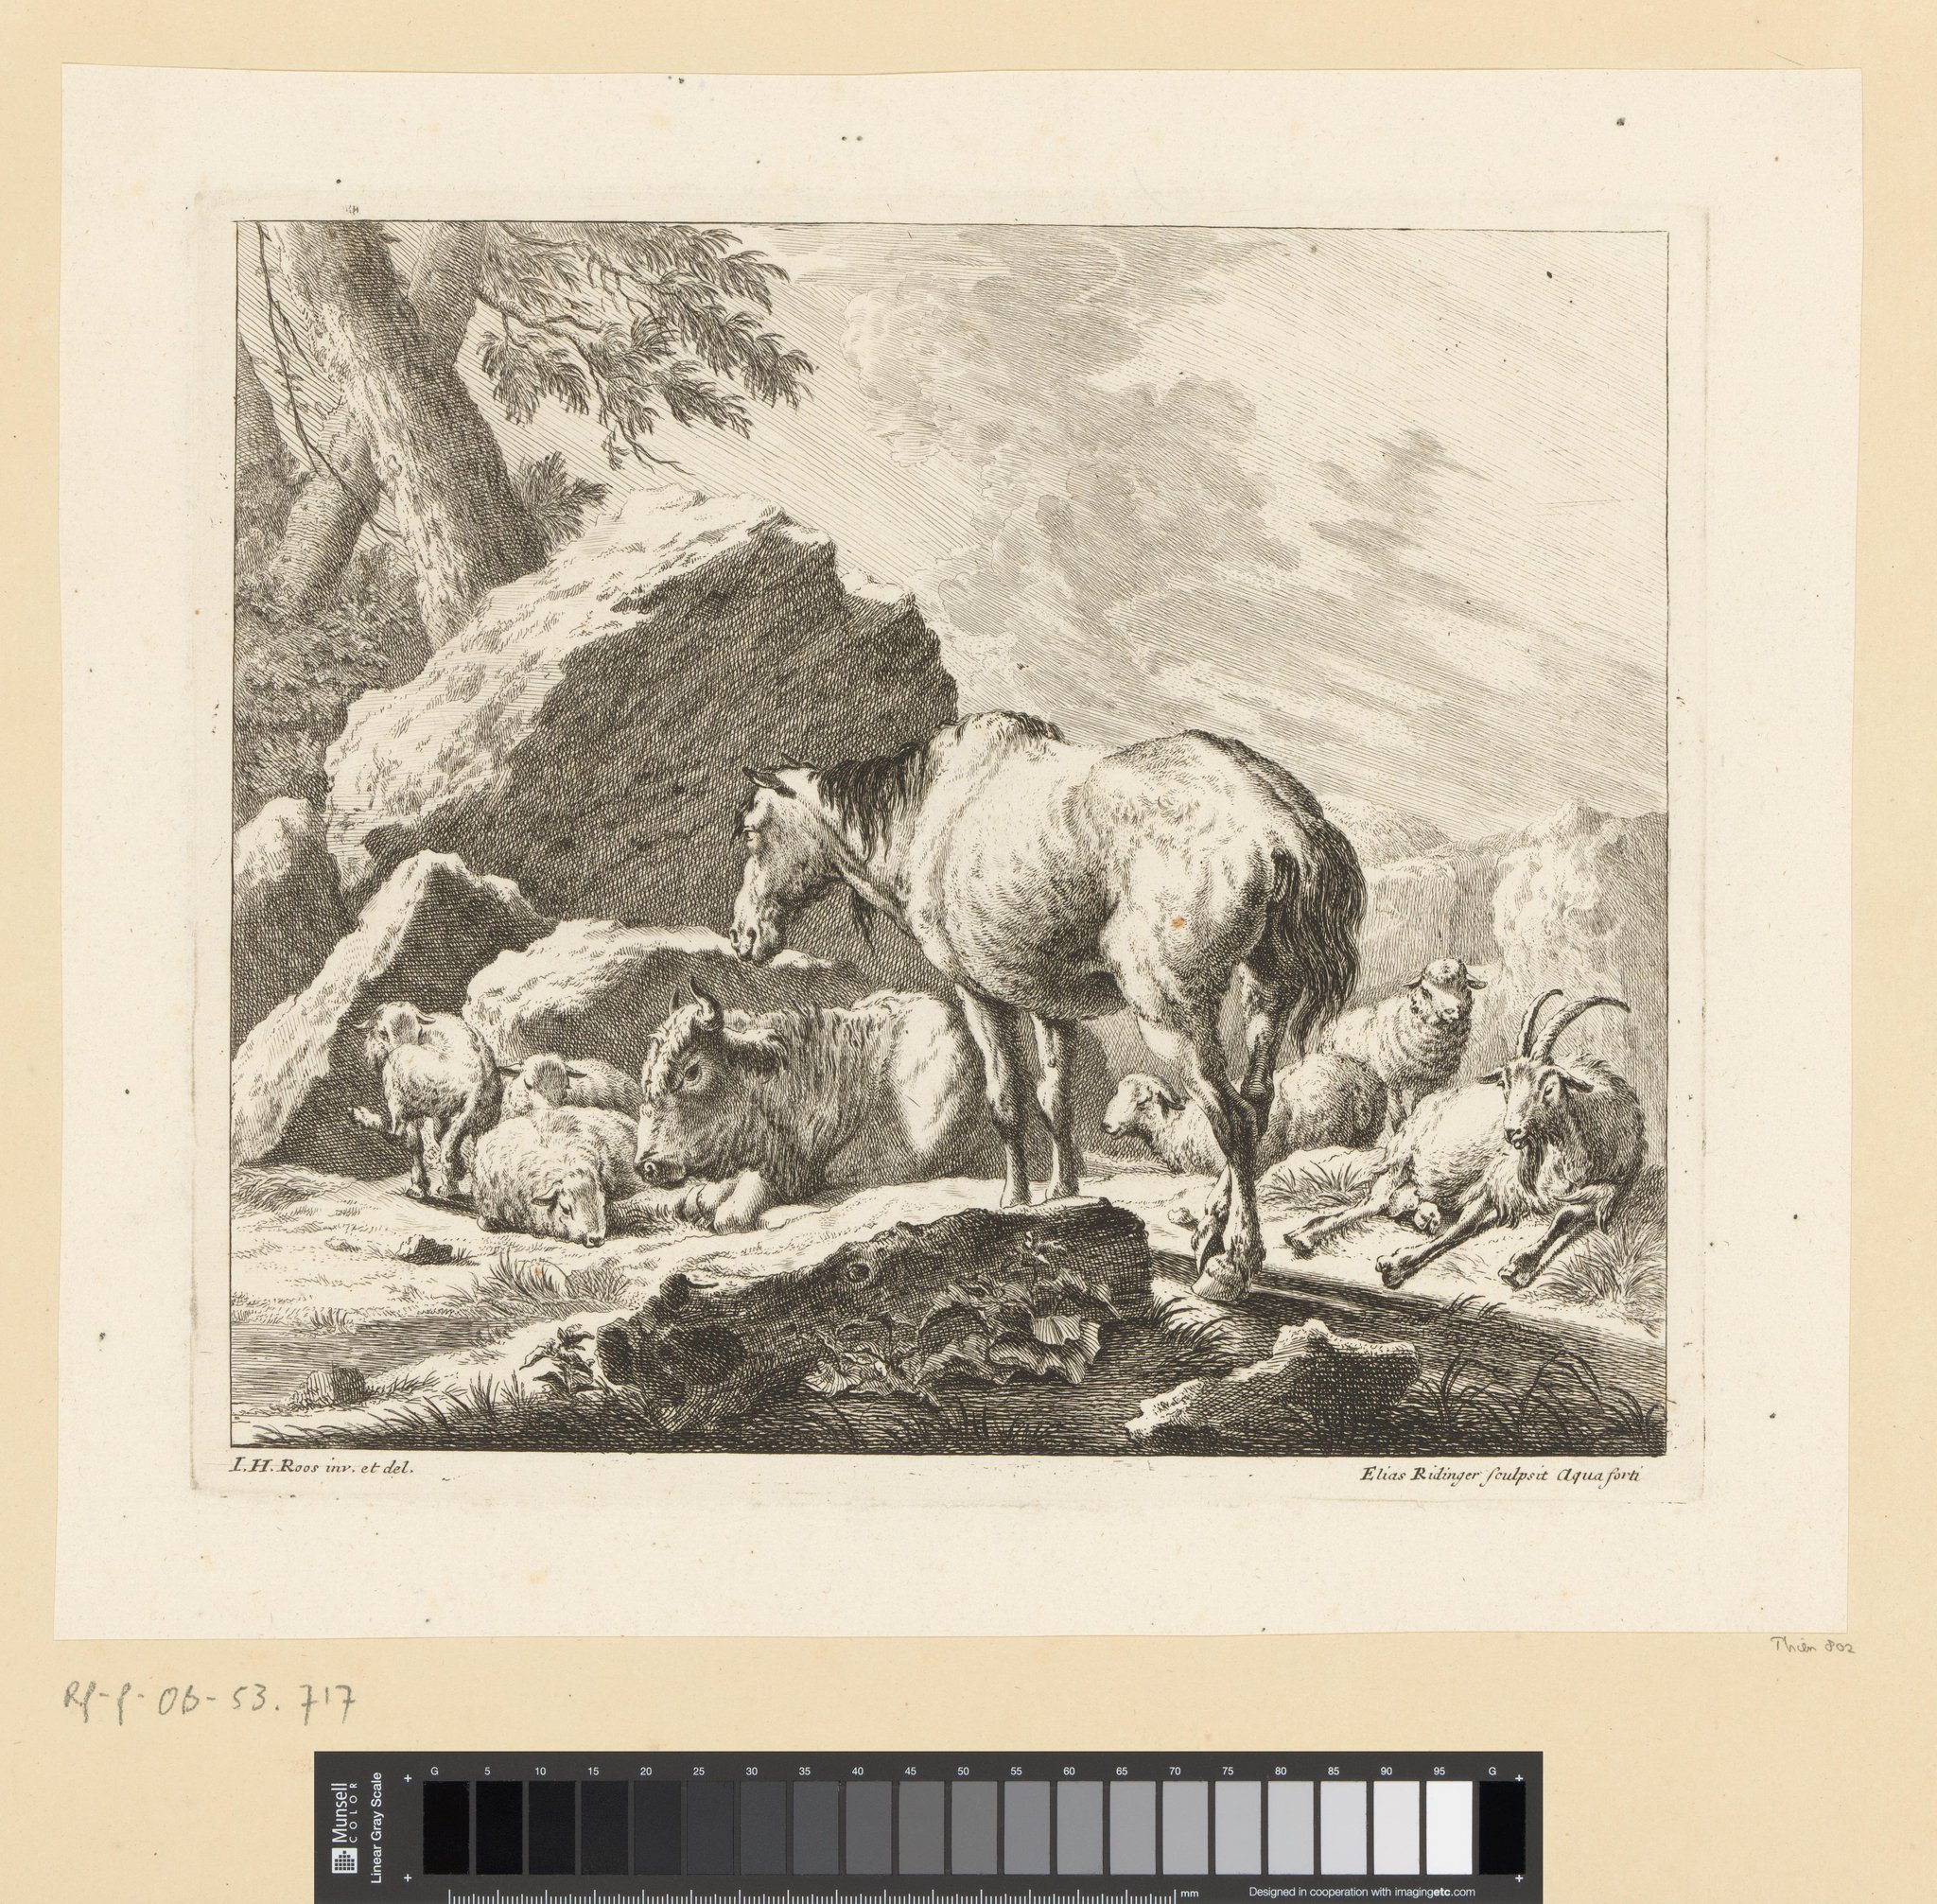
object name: print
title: Kudde schapen, geit, rund en paard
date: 1708-1767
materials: paper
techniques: etching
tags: landscapes, cattle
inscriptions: collector's mark: Lugt 240